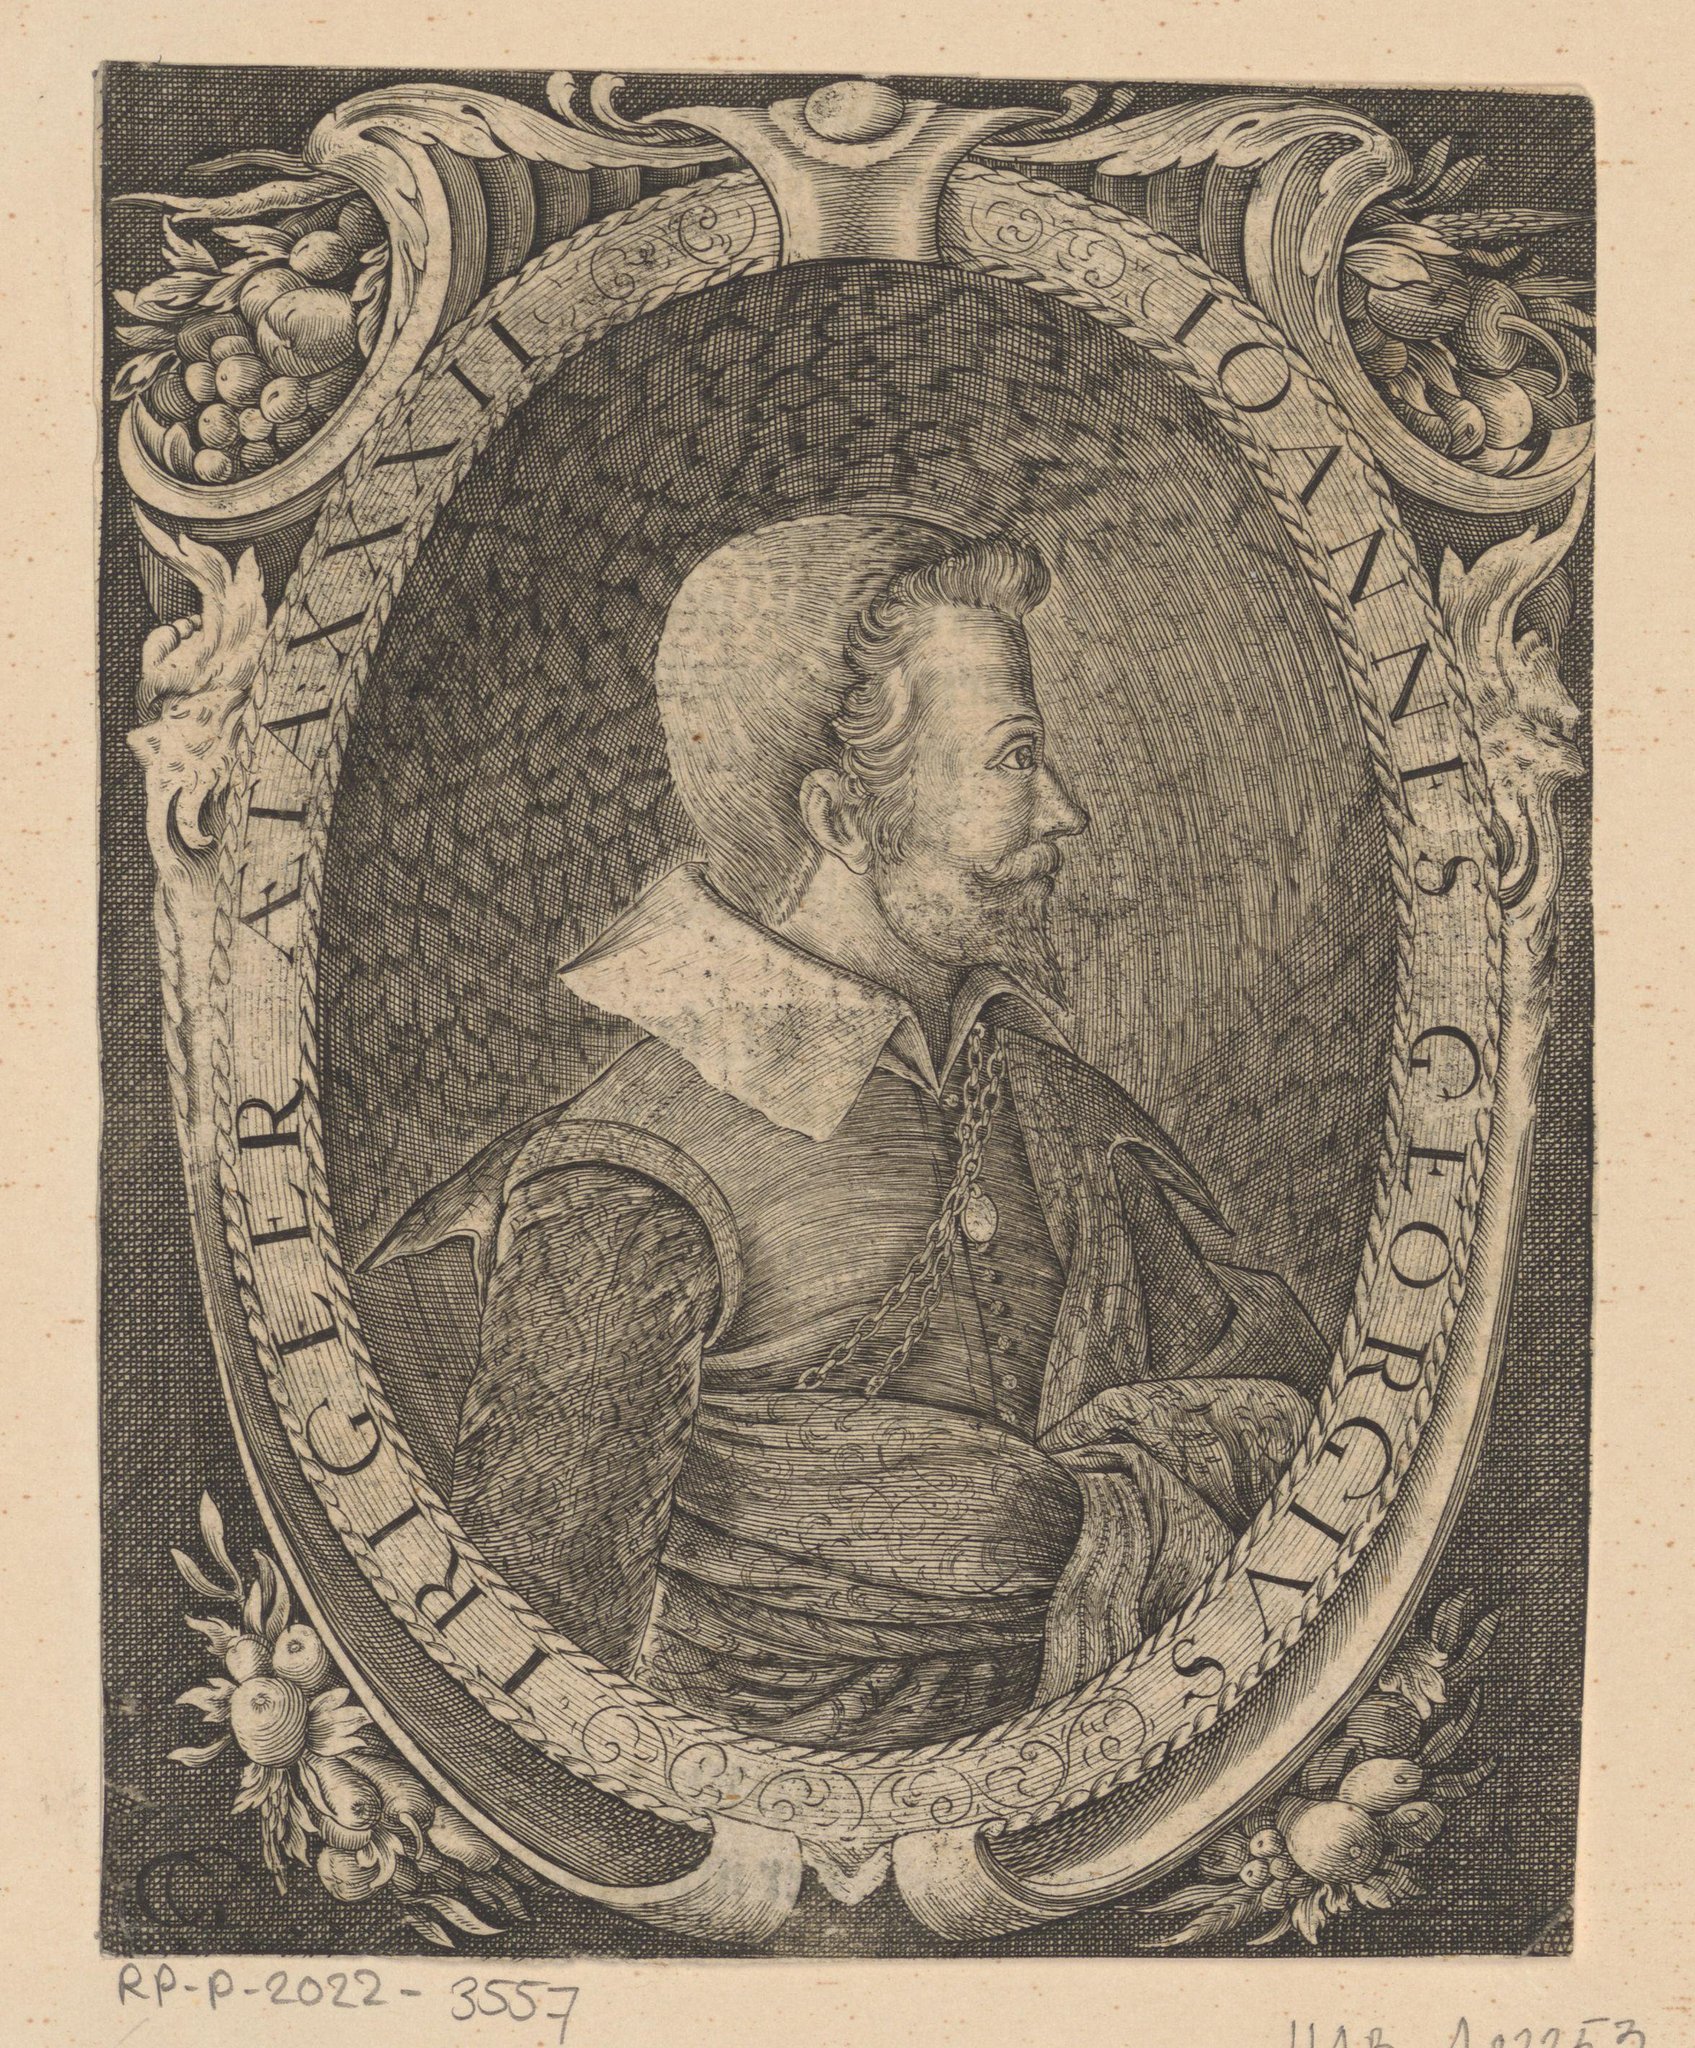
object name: print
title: Portret van Johann Georg Trigler op 32-jarige leeftijd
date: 1614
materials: paper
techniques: engraving, etching, letterpress printing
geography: germany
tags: historical persons, astronomy (and cosmography) (+ scholar, scientist in non-work situations)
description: Prent uit: Trigler, Johann Georg. Sphaera, das ist ein kurtzes astronomisches Tractätlein von der Sphaera und dem Himmelslauf (...). Leipzig: Henning Grosse., 1614.